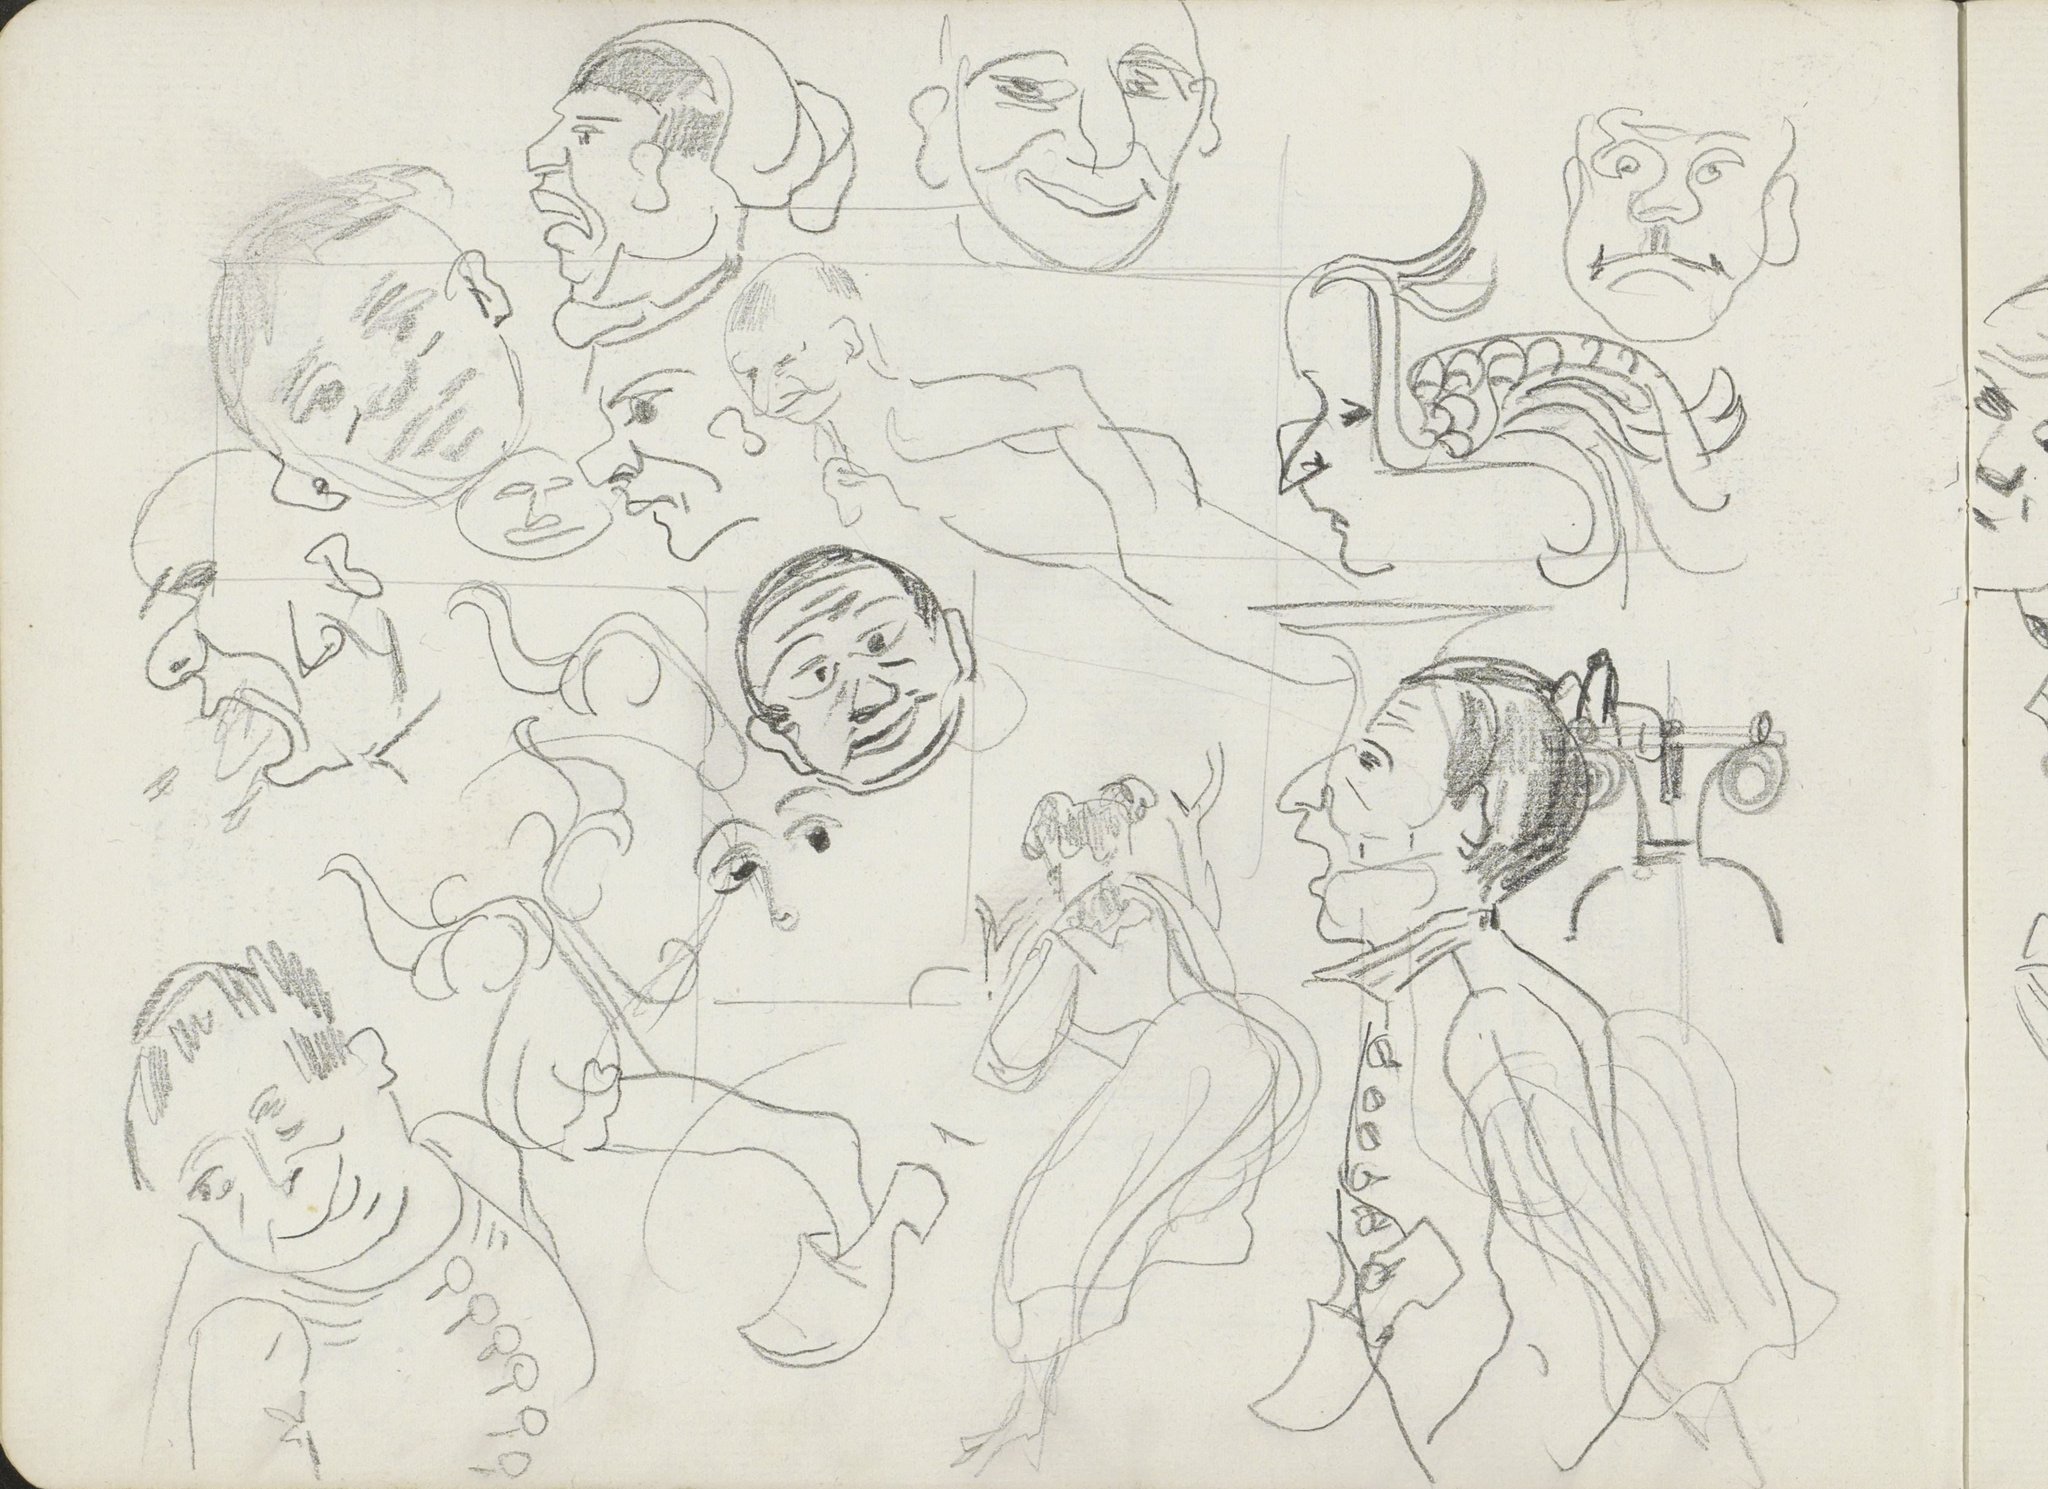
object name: sketchbook leaf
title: Karikaturale koppen en fantasiefiguren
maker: carel adolph lion cachet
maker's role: draughtsman, print maker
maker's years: 1864-1945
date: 1905-1910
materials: paper, pencil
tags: head (human)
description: Blad 2 verso uit een schetsboek met 27 bladen.